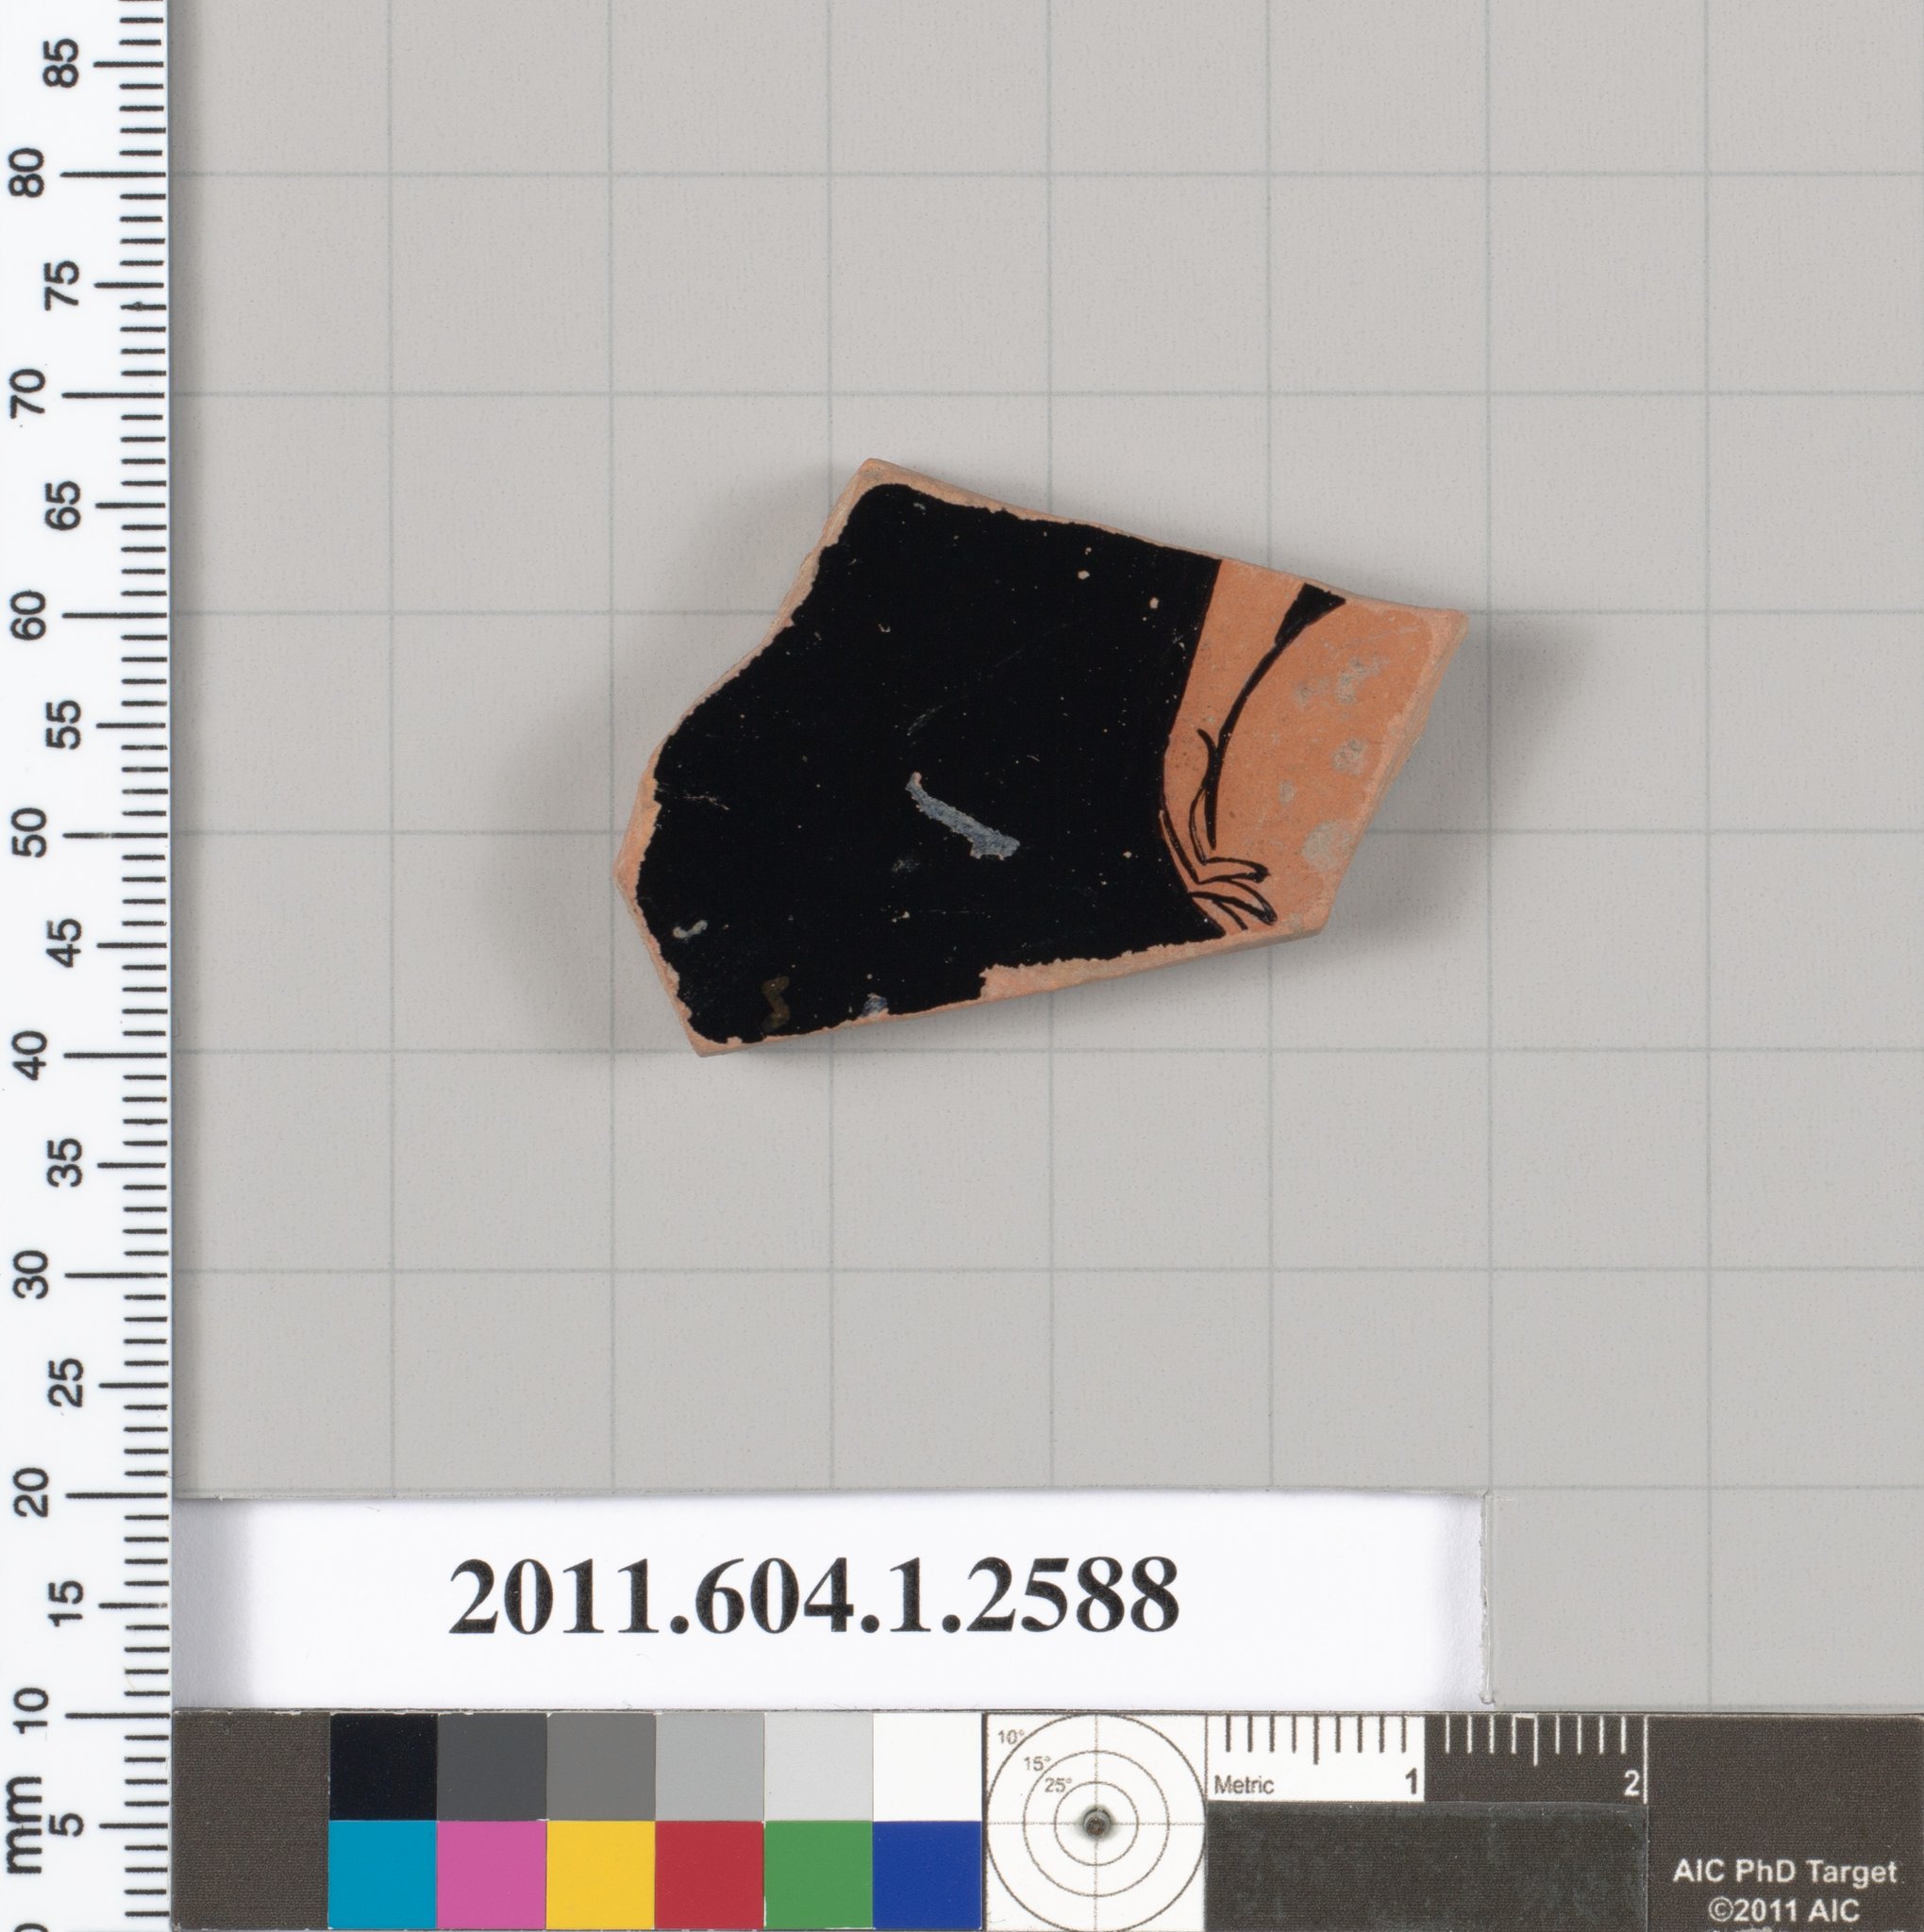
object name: kylix fragment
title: Terracotta fragment of a kylix (drinking cup)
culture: greek, attic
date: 490-480 BCE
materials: terracotta